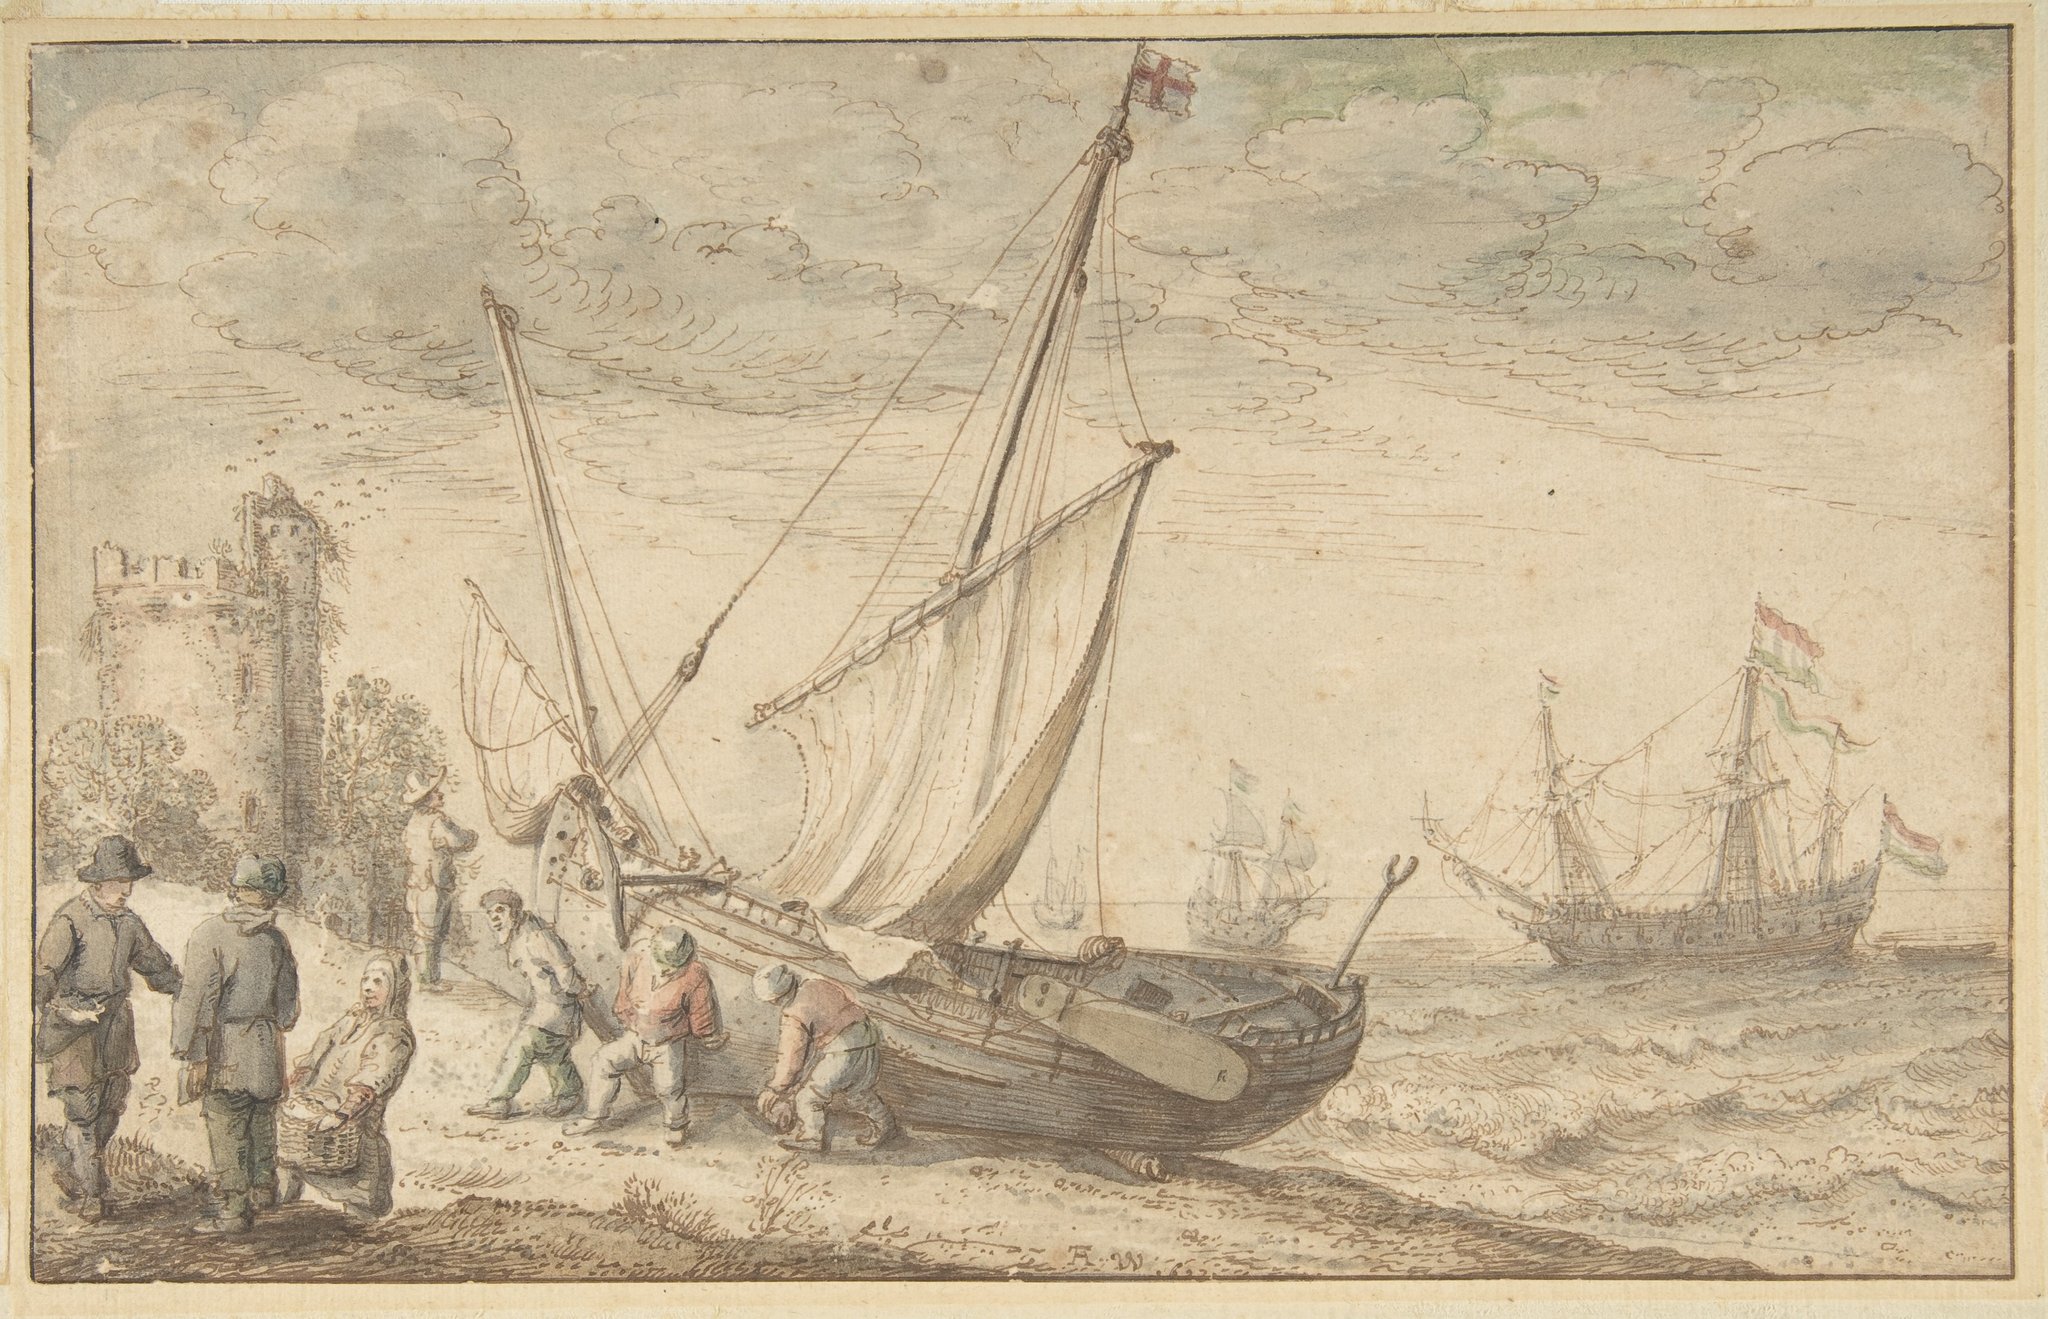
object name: drawing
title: Fisherfolk Hauling their Boat onto the Shore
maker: adam willaerts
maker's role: artist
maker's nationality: netherlandish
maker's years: 1577-1664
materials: chalk, ink, watercolor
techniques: pen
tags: men,boats